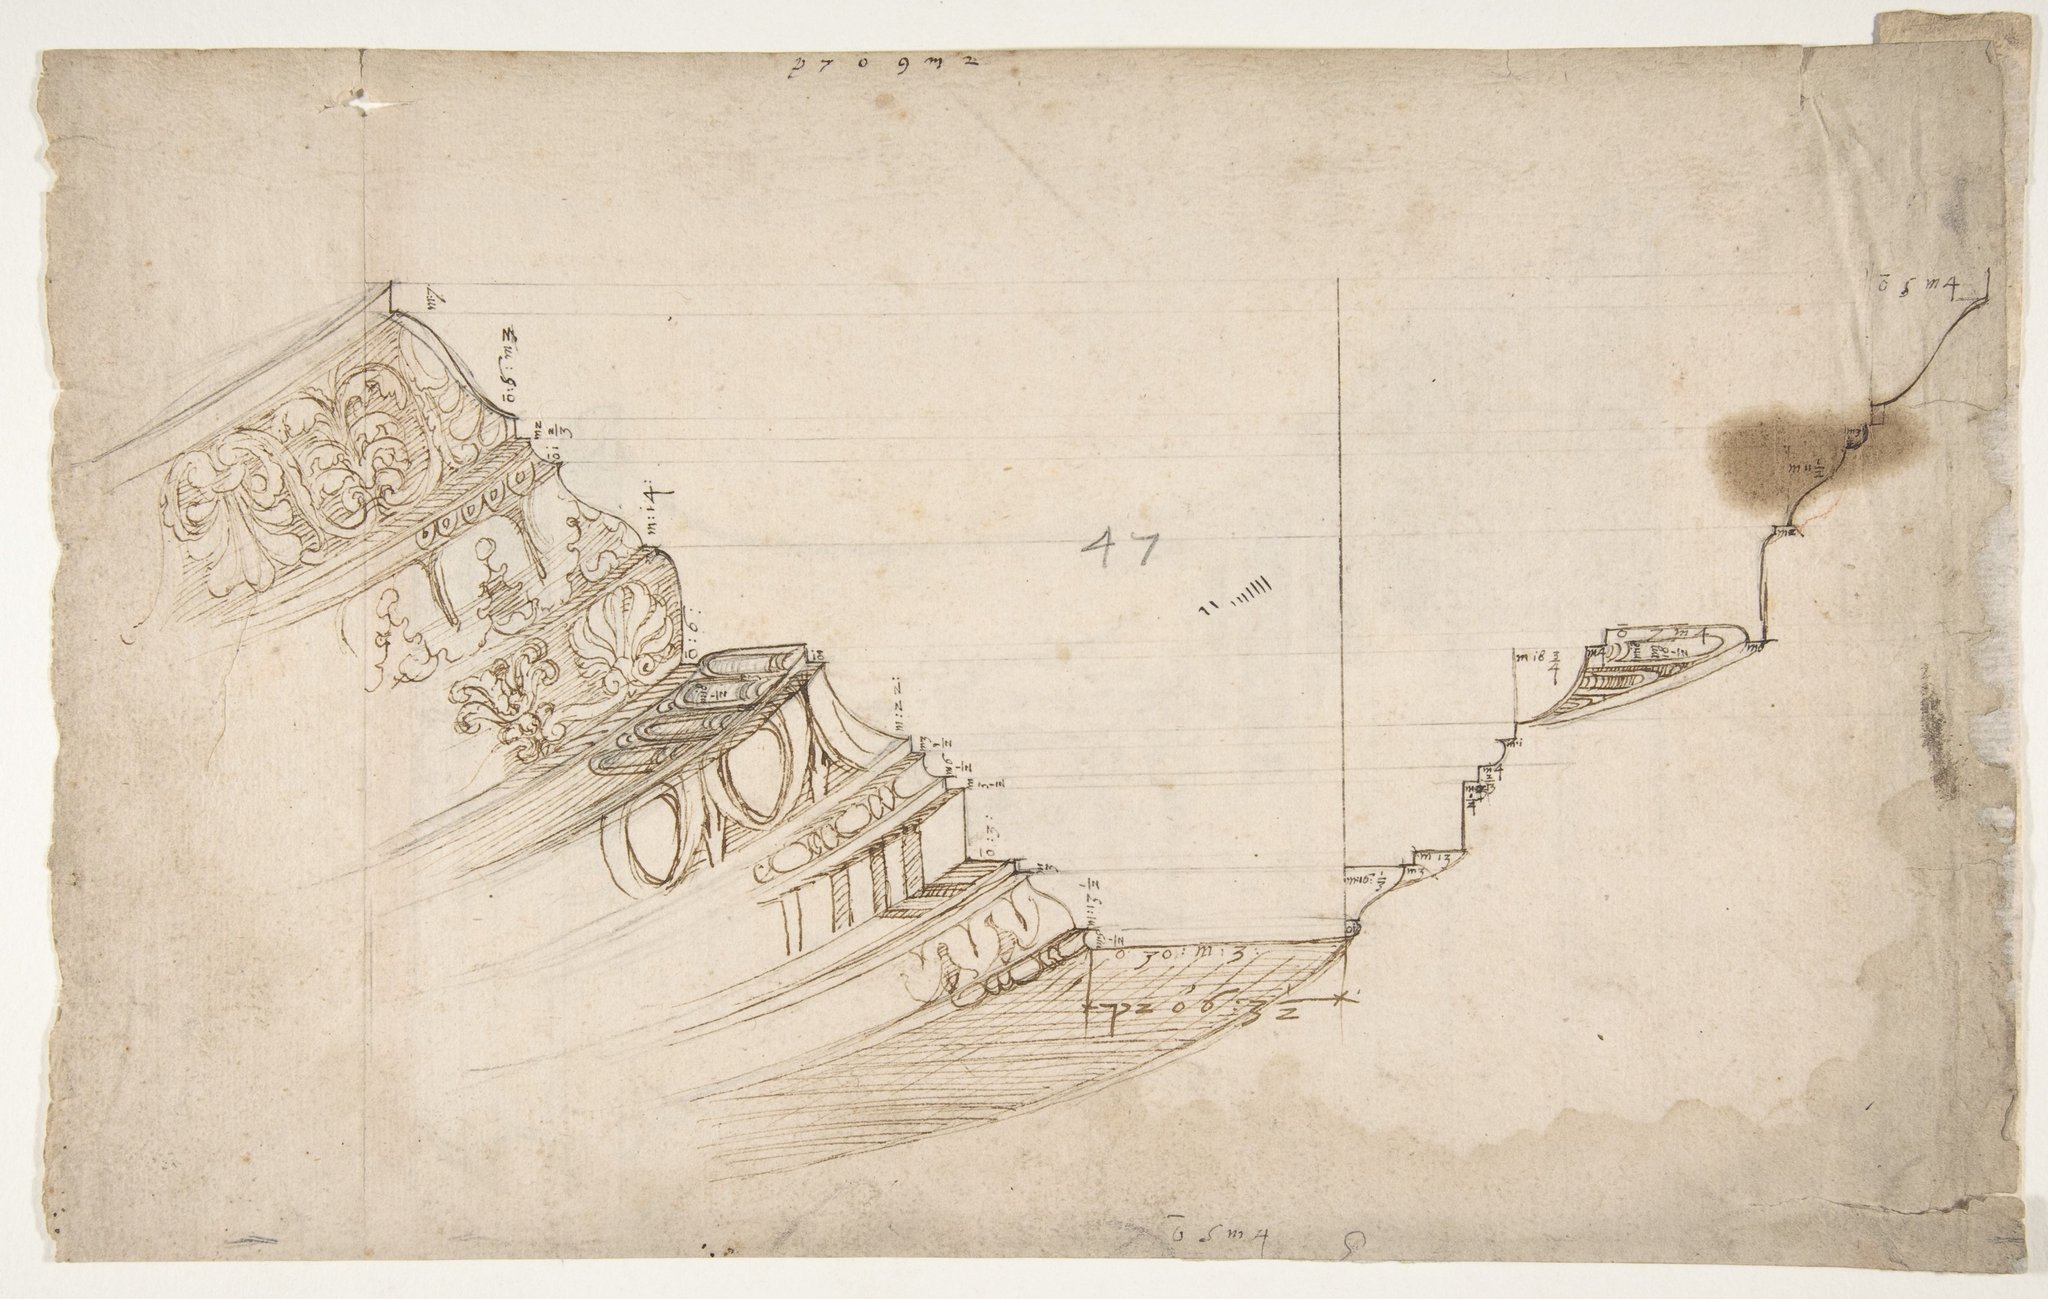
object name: collection ornament architecture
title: Domus Augustiana, cornice, profile projection (recto) Ara Grimani, base (verso)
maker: anonymous, french, 16th century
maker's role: draftsman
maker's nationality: french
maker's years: 1500-1600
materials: chalk, ink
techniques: incising